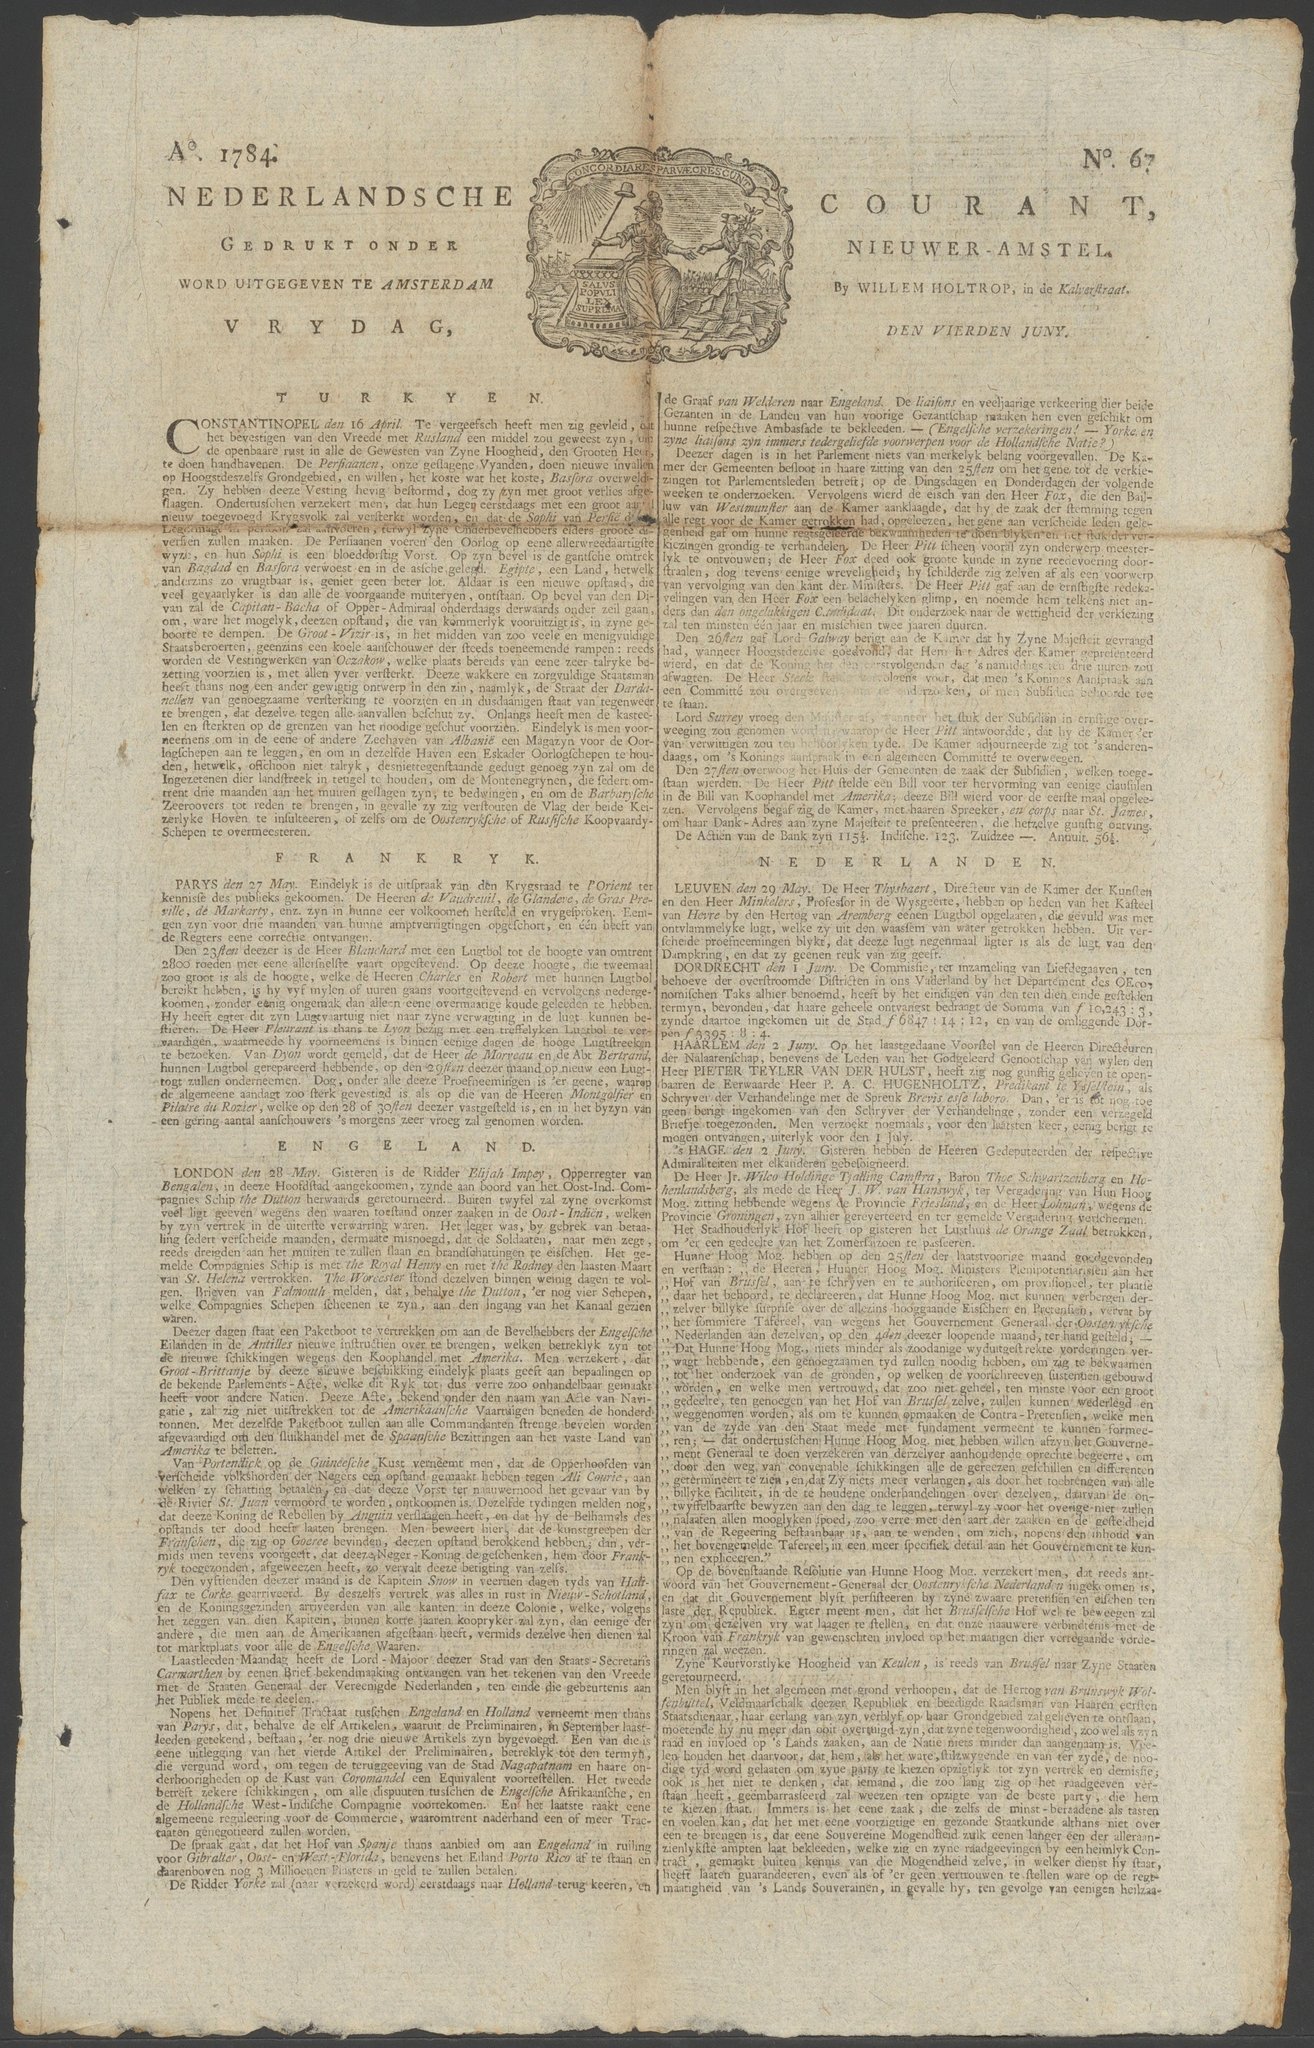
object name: newspaper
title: Nederlandsche Courant, 4 juni 1784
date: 1784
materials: paper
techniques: letterpress printing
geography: amsterdam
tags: newspaper, news-sheet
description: Exemplaar van de krant 'Nederlandsche Courant' van 4 juni 1784. Enkelbladig, beide zijden bedrukt. Bovenaan een vignet met de Vrijheid en Mercurius. Onderwerpsrubrieken binnen de Atlas Zeden en Gewoonten: Regeering, Officieele Nieuwsbladen.